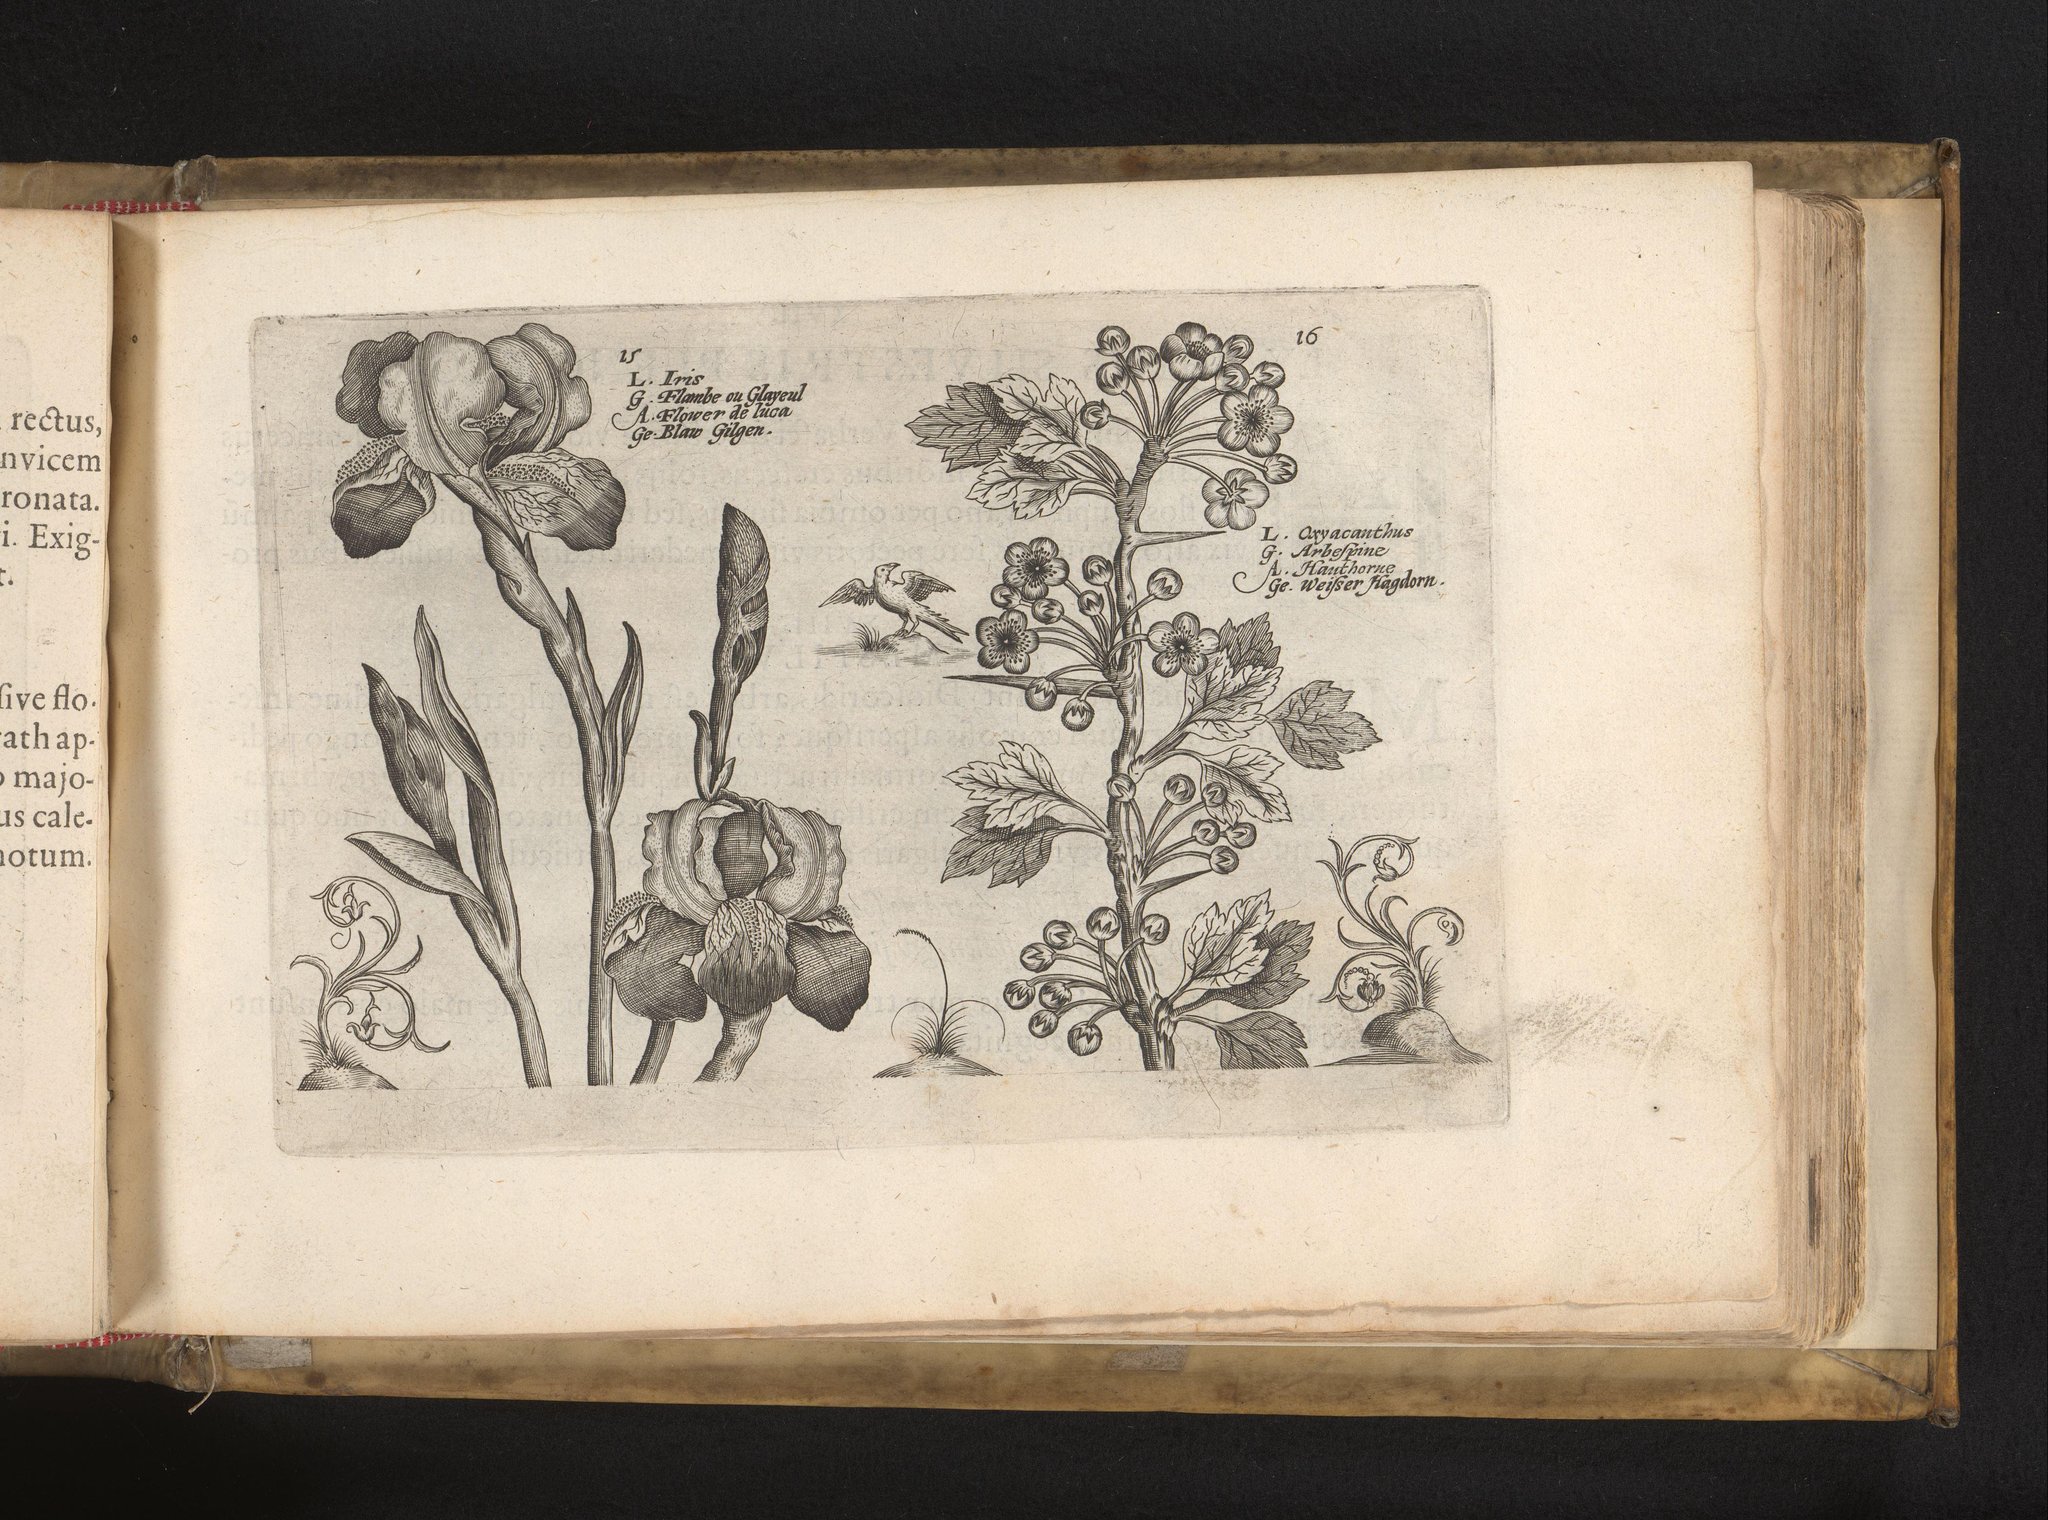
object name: book illustration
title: Bloementuin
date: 1617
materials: paper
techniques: engraving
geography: arnhem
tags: flowers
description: Prent uit: Passe, Crispijn van de (II). Hortus floridus in quo rariorum & minus vulgarium florum icones ad vivam veramque formam. Arnhem: Johannes Janssonius, 1617.